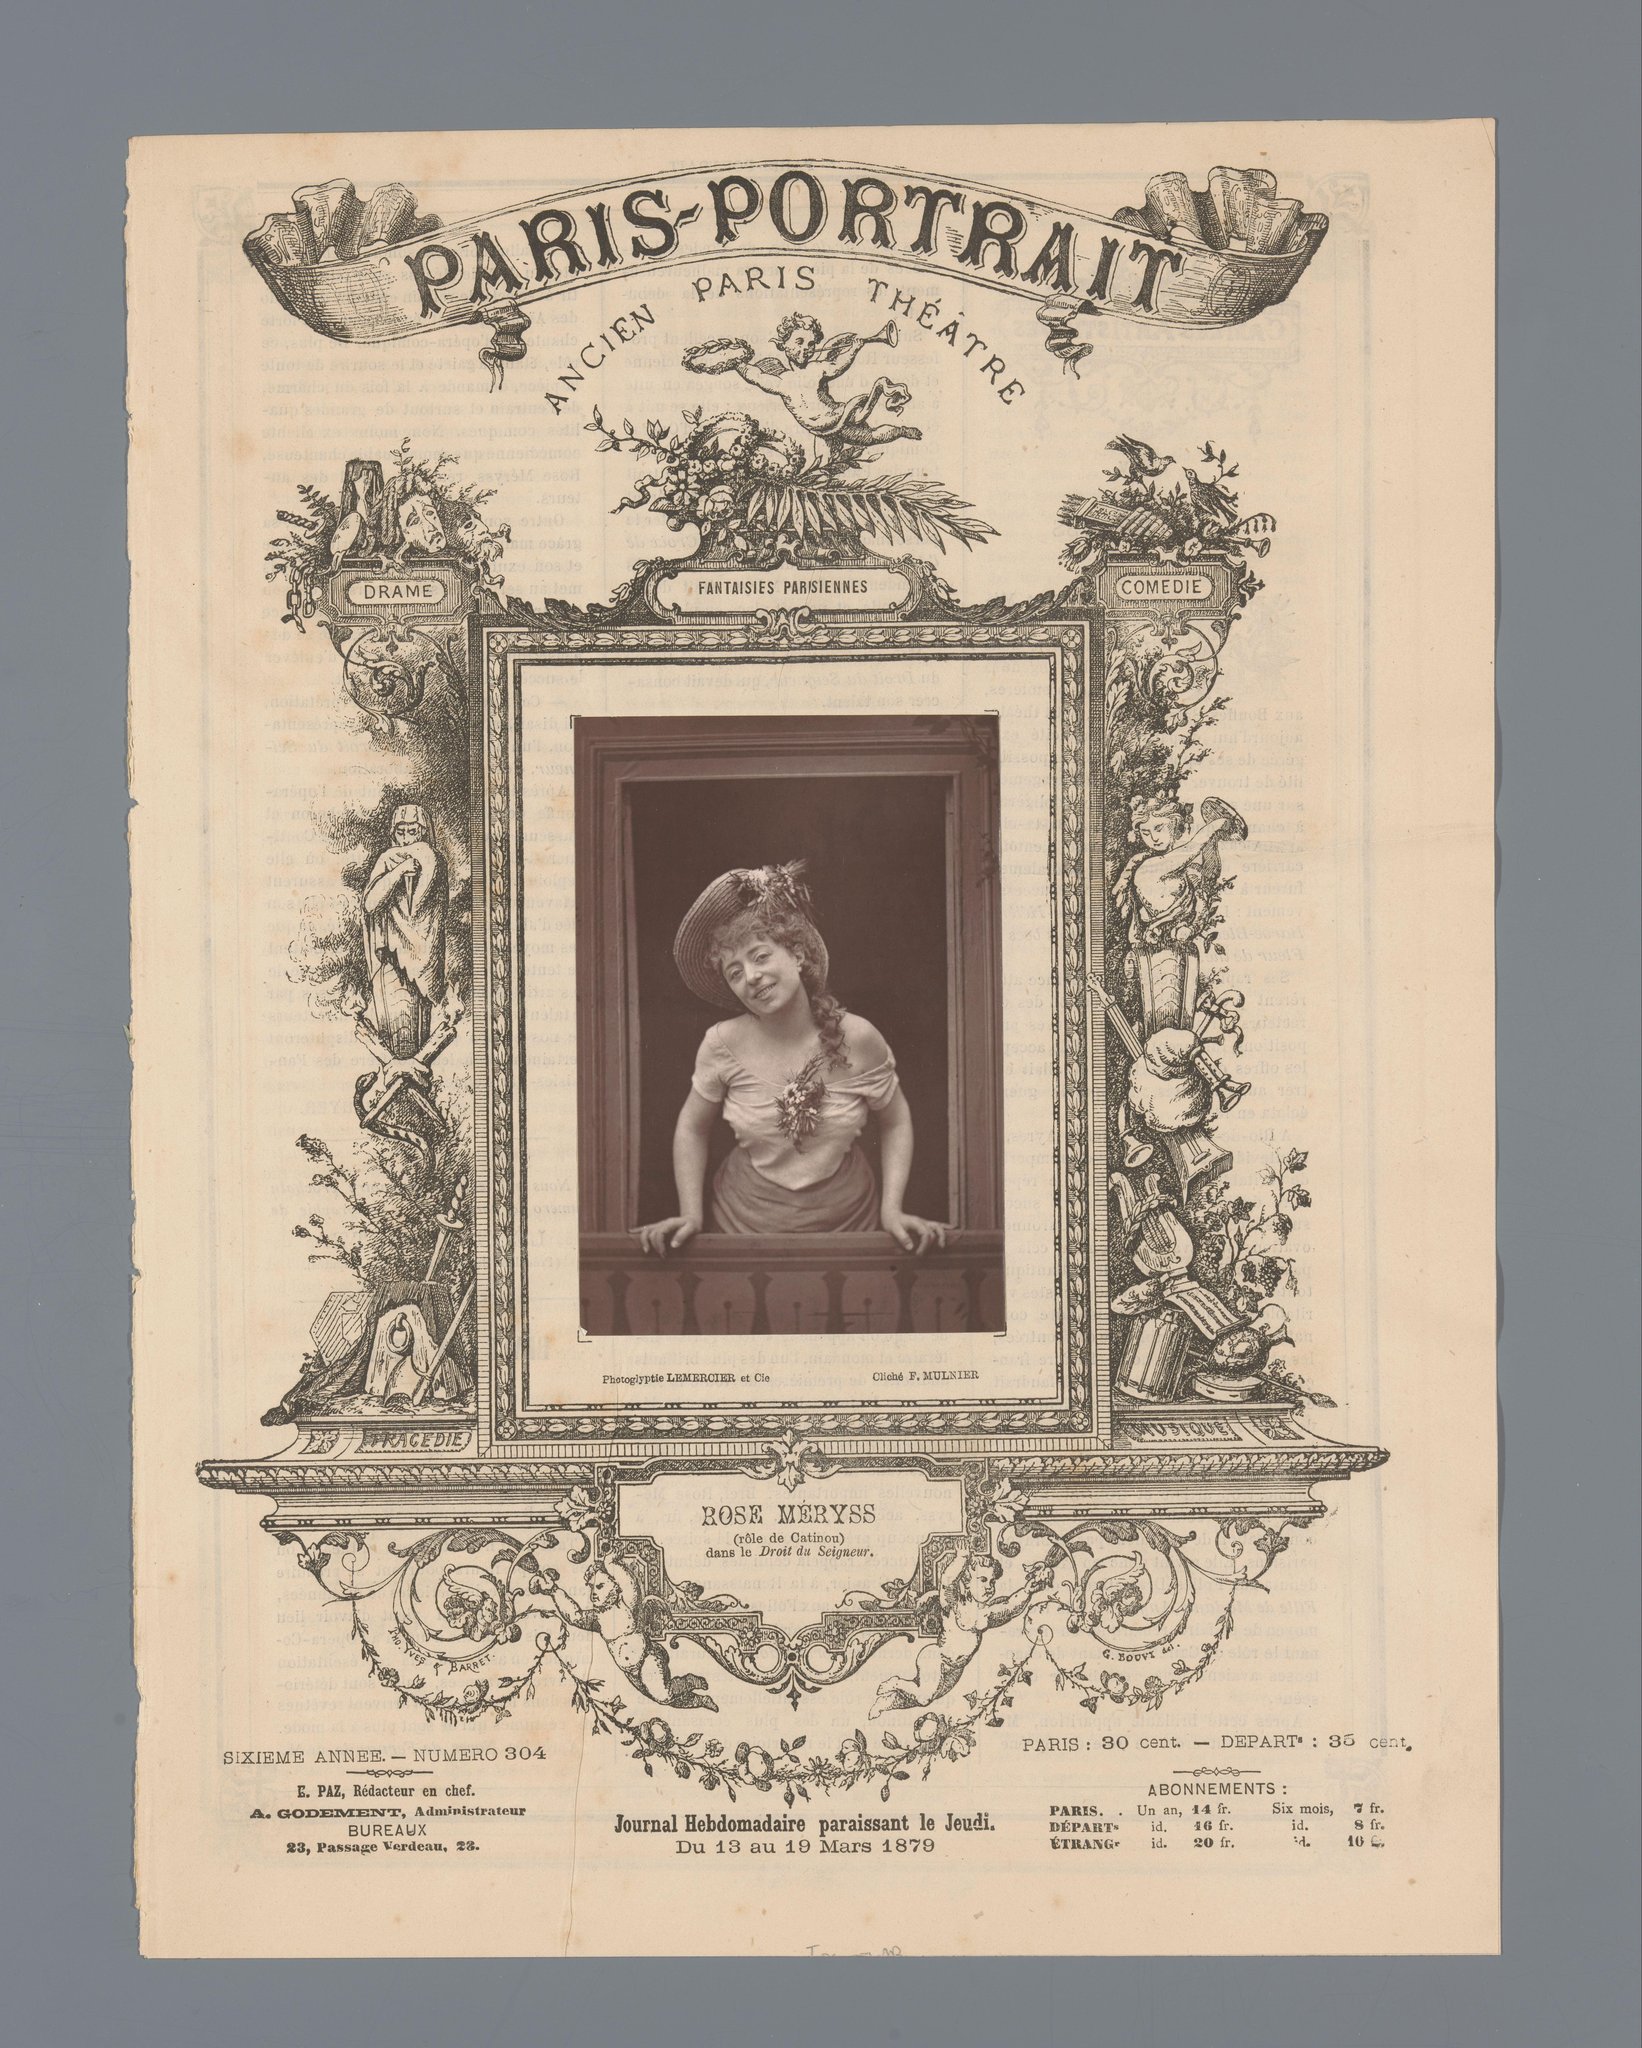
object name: photomechanical print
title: Portret van Rose Méryss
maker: ferdinand mulnier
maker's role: painter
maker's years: 1817-1891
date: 1873-1880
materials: paper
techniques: woodburytype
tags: historical persons - bb - woman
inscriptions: inscription: ‘(rôle de Catinou) dans le Droit du Seigneur’